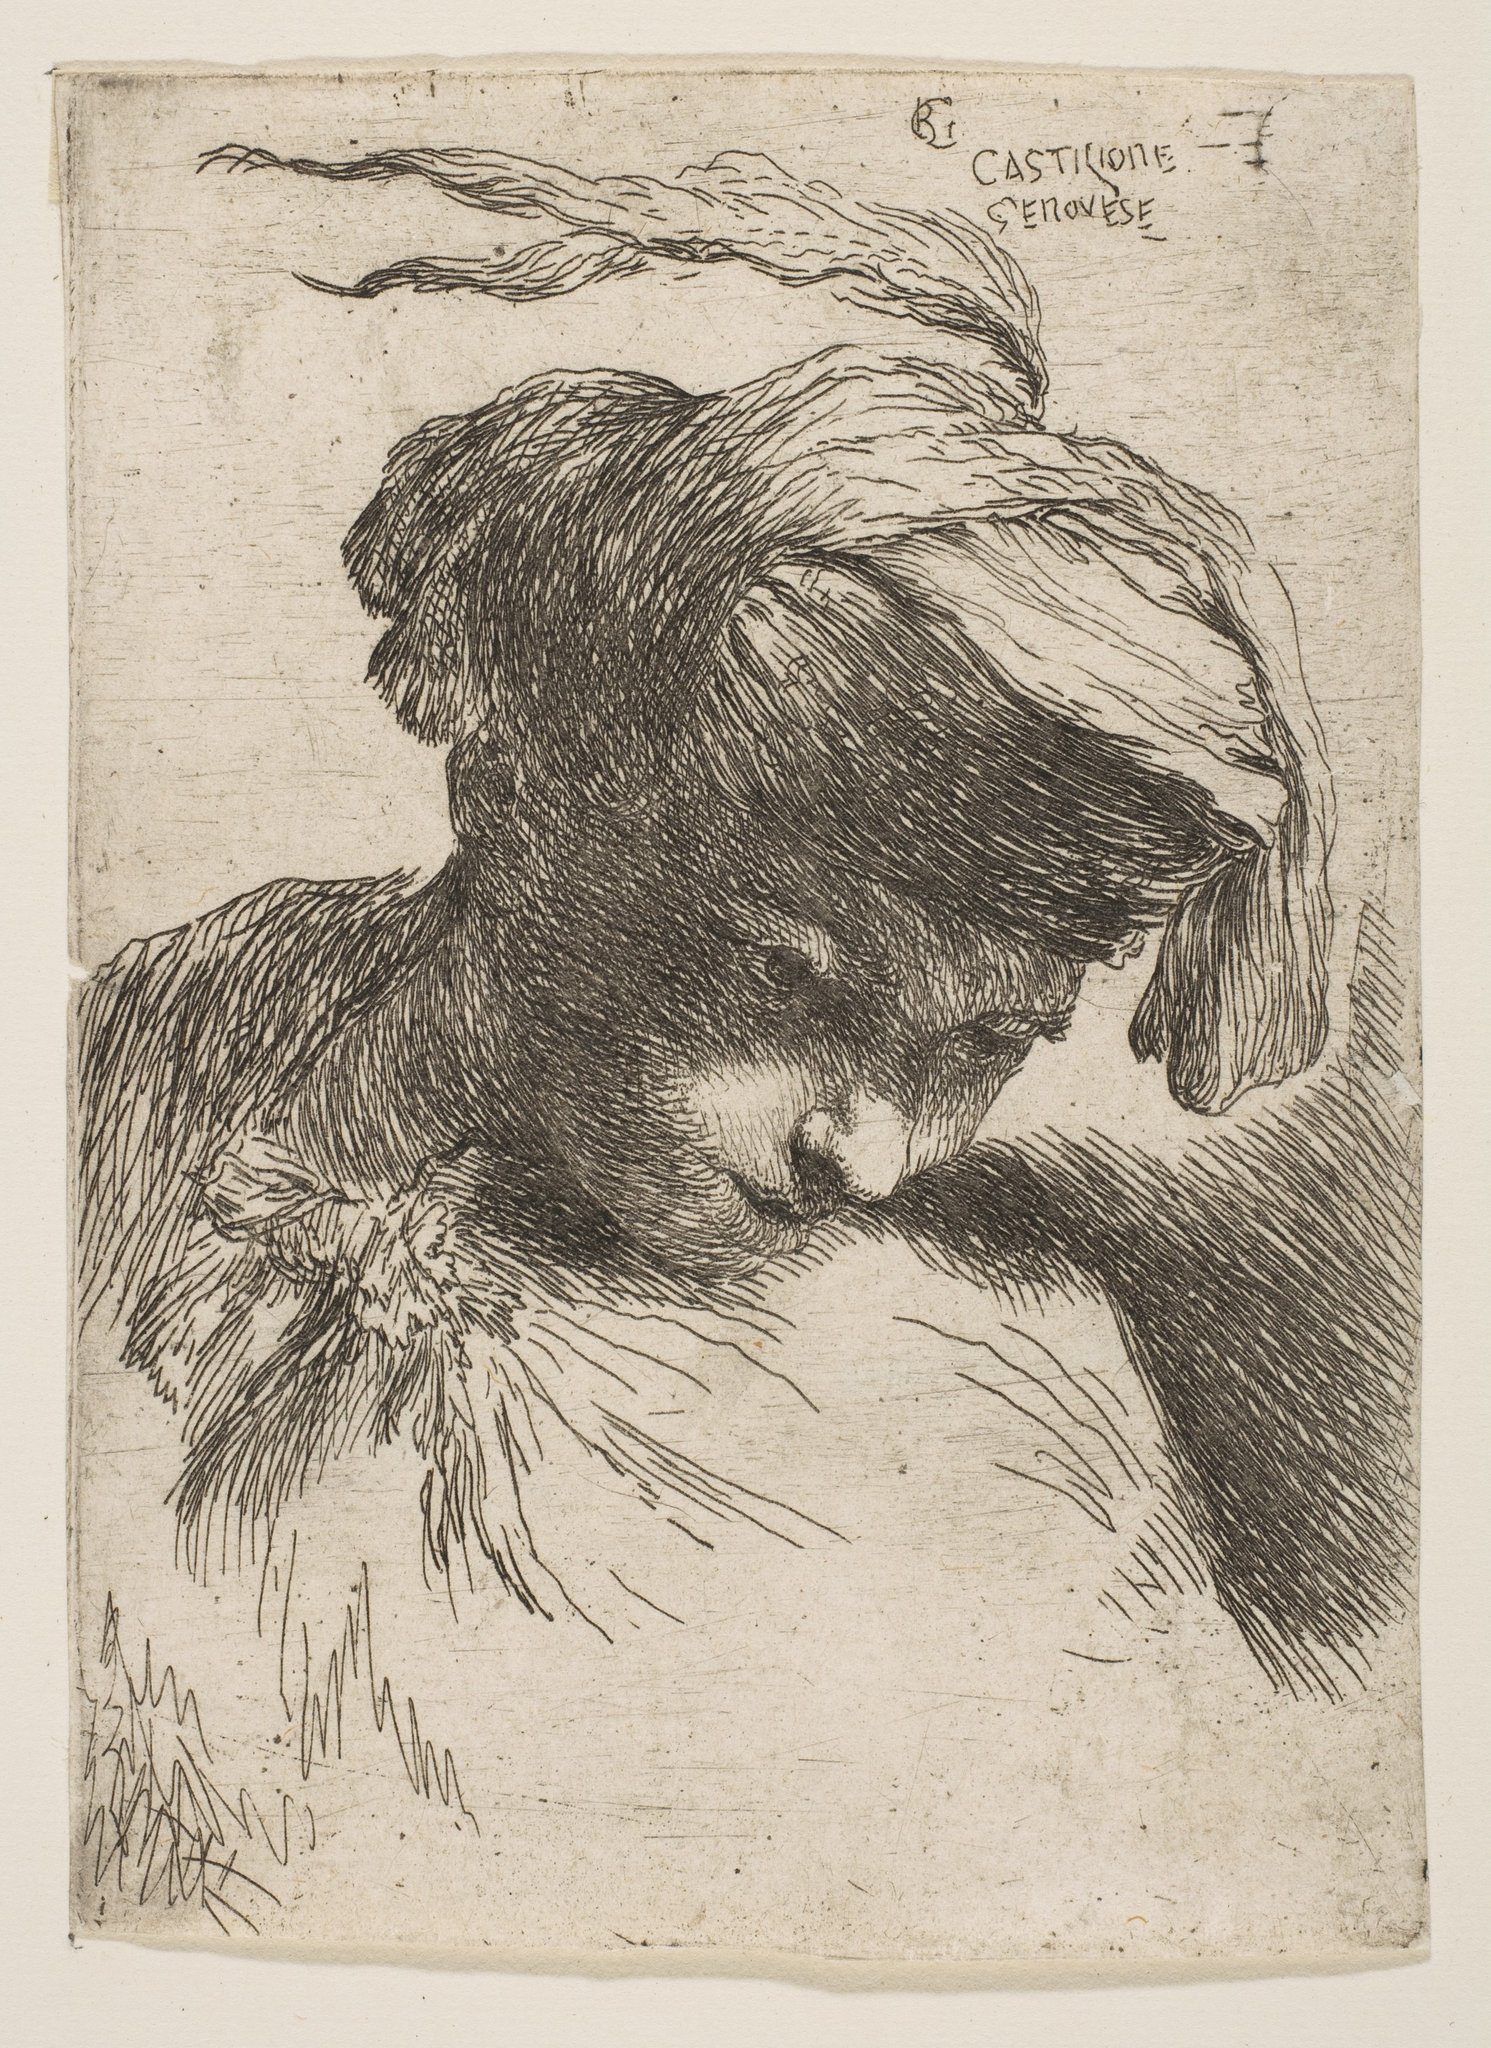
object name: print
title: Young man looking down to right, from "Small Heads in Oriental Headdress"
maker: giovanni benedetto castiglione (il grechetto)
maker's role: artist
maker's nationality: italian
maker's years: 1609-1664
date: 1645-1650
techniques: etching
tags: men